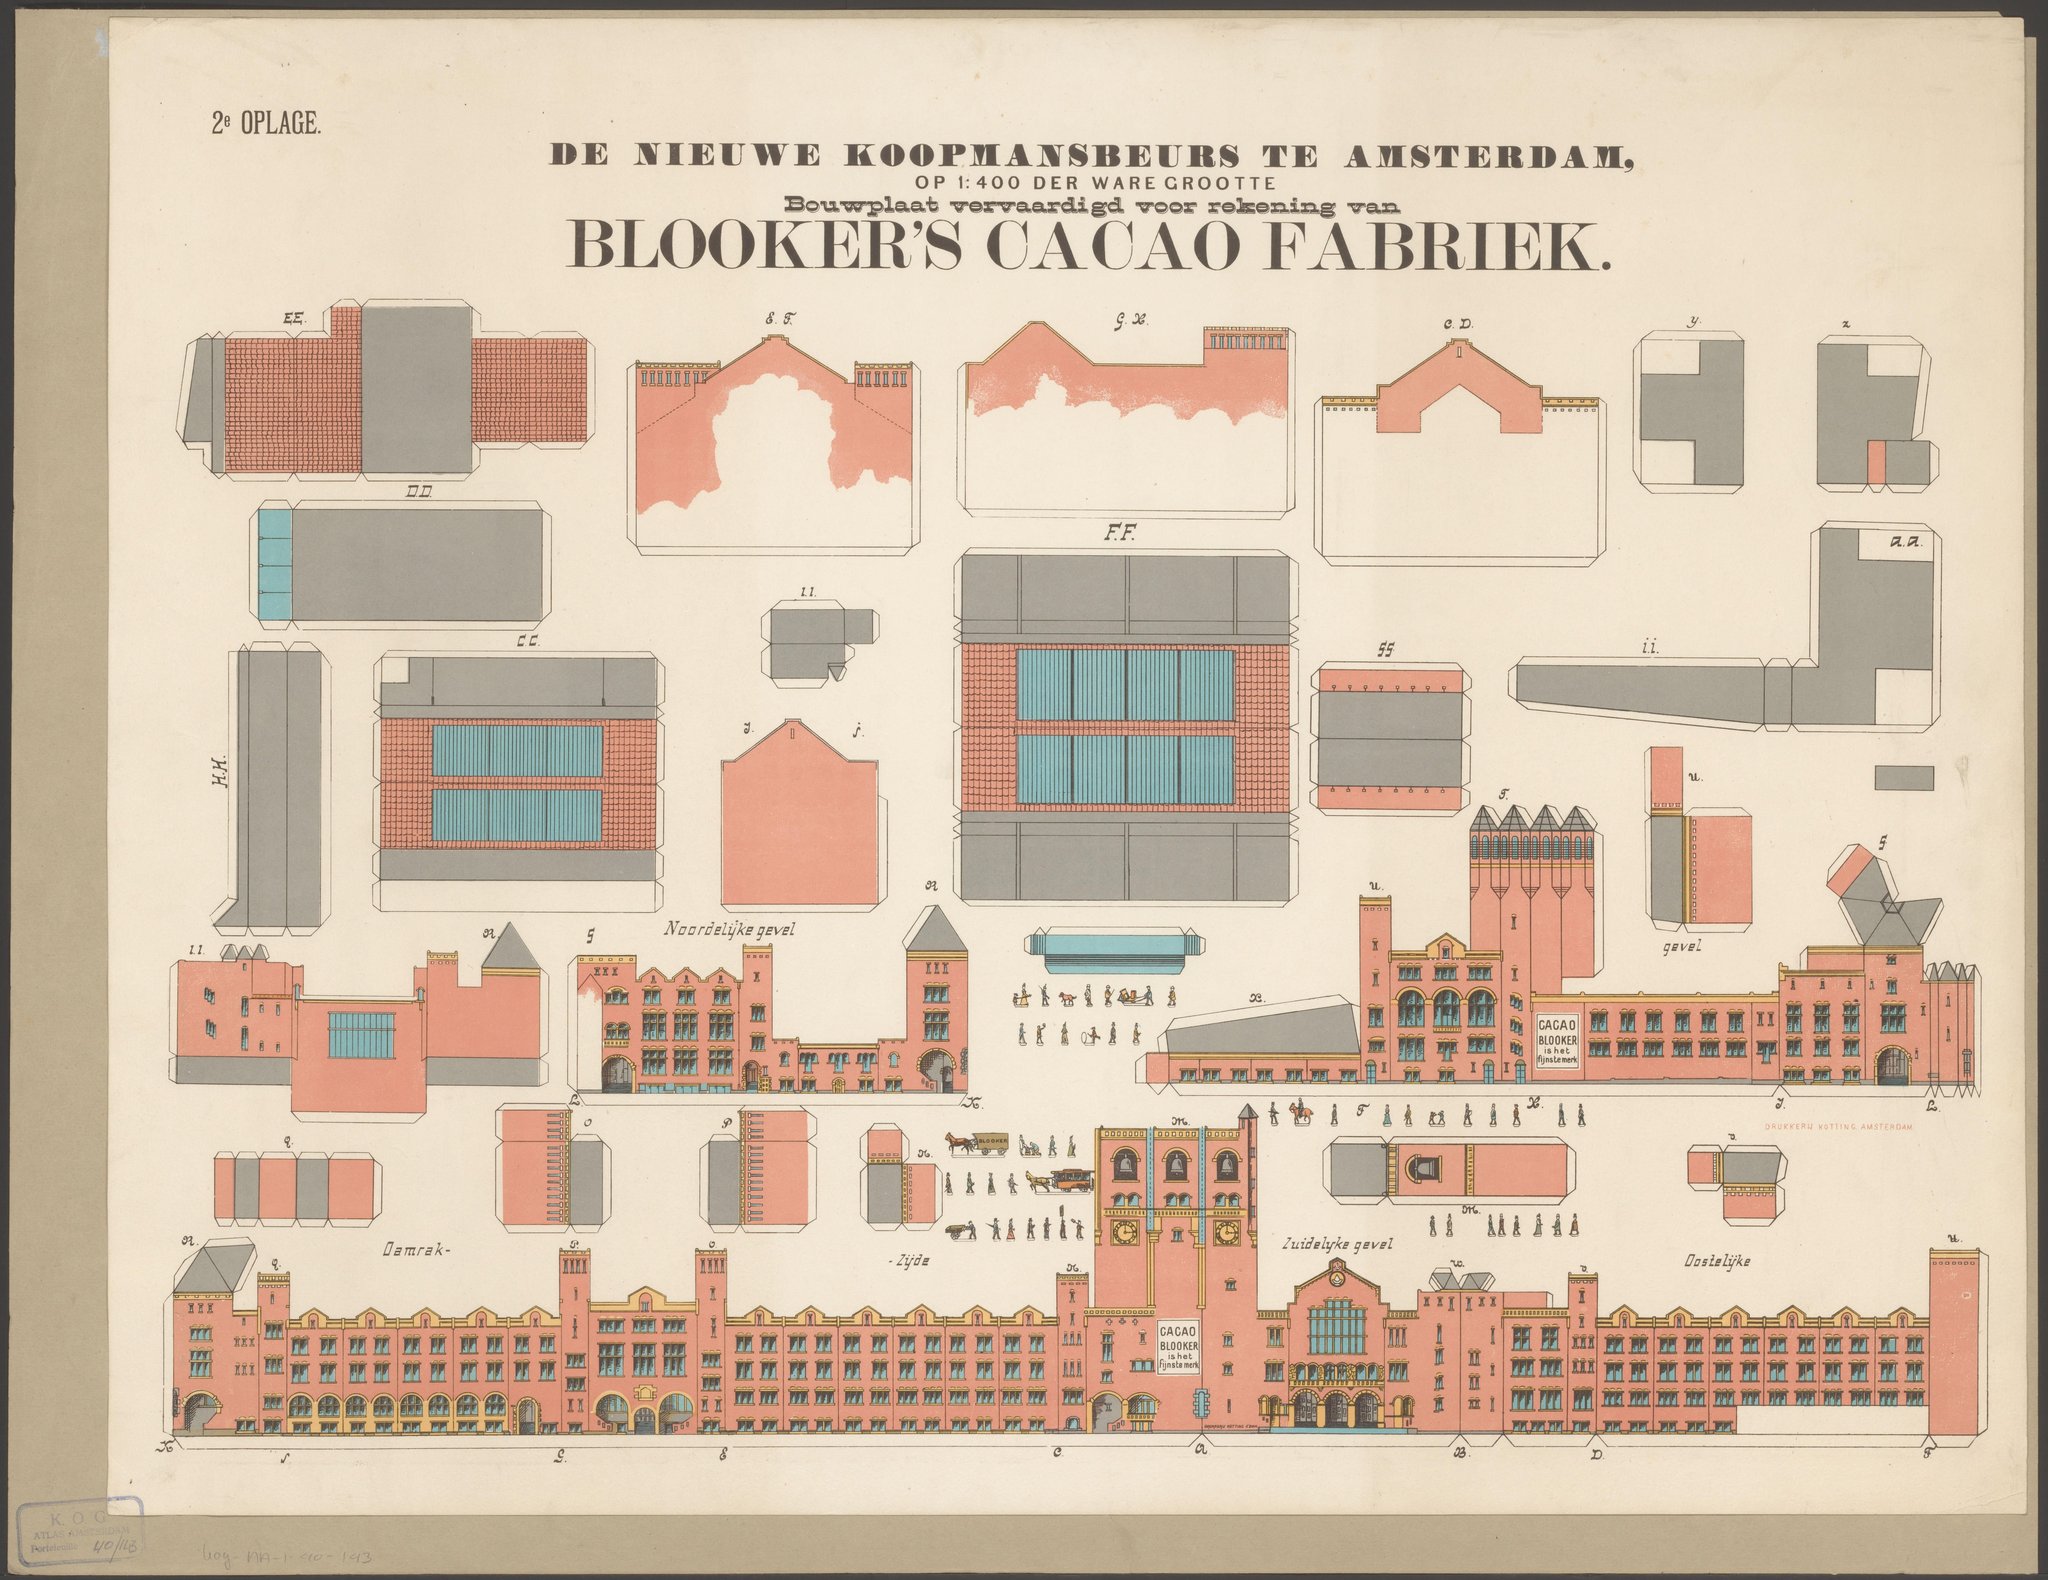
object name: print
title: De nieuwe koopmansbeurs te Amsterdam (...)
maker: johan braakensiek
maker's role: draughtsman, print maker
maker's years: 1858-1940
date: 1893-1897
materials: paper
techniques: line block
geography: amsterdam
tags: design, plan (~ production), stock exchange, stock-market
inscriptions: collector's mark: Lugt 1641b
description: Bouwplaat van een nieuwe koopmansbeurs, verspreid door de Blooker's Cacao Fabriek. Onderwerpsrubriek binnen de Atlas Amsterdam: Handel en Zeevaart, E. Spotprenten betreffende de Beurs.